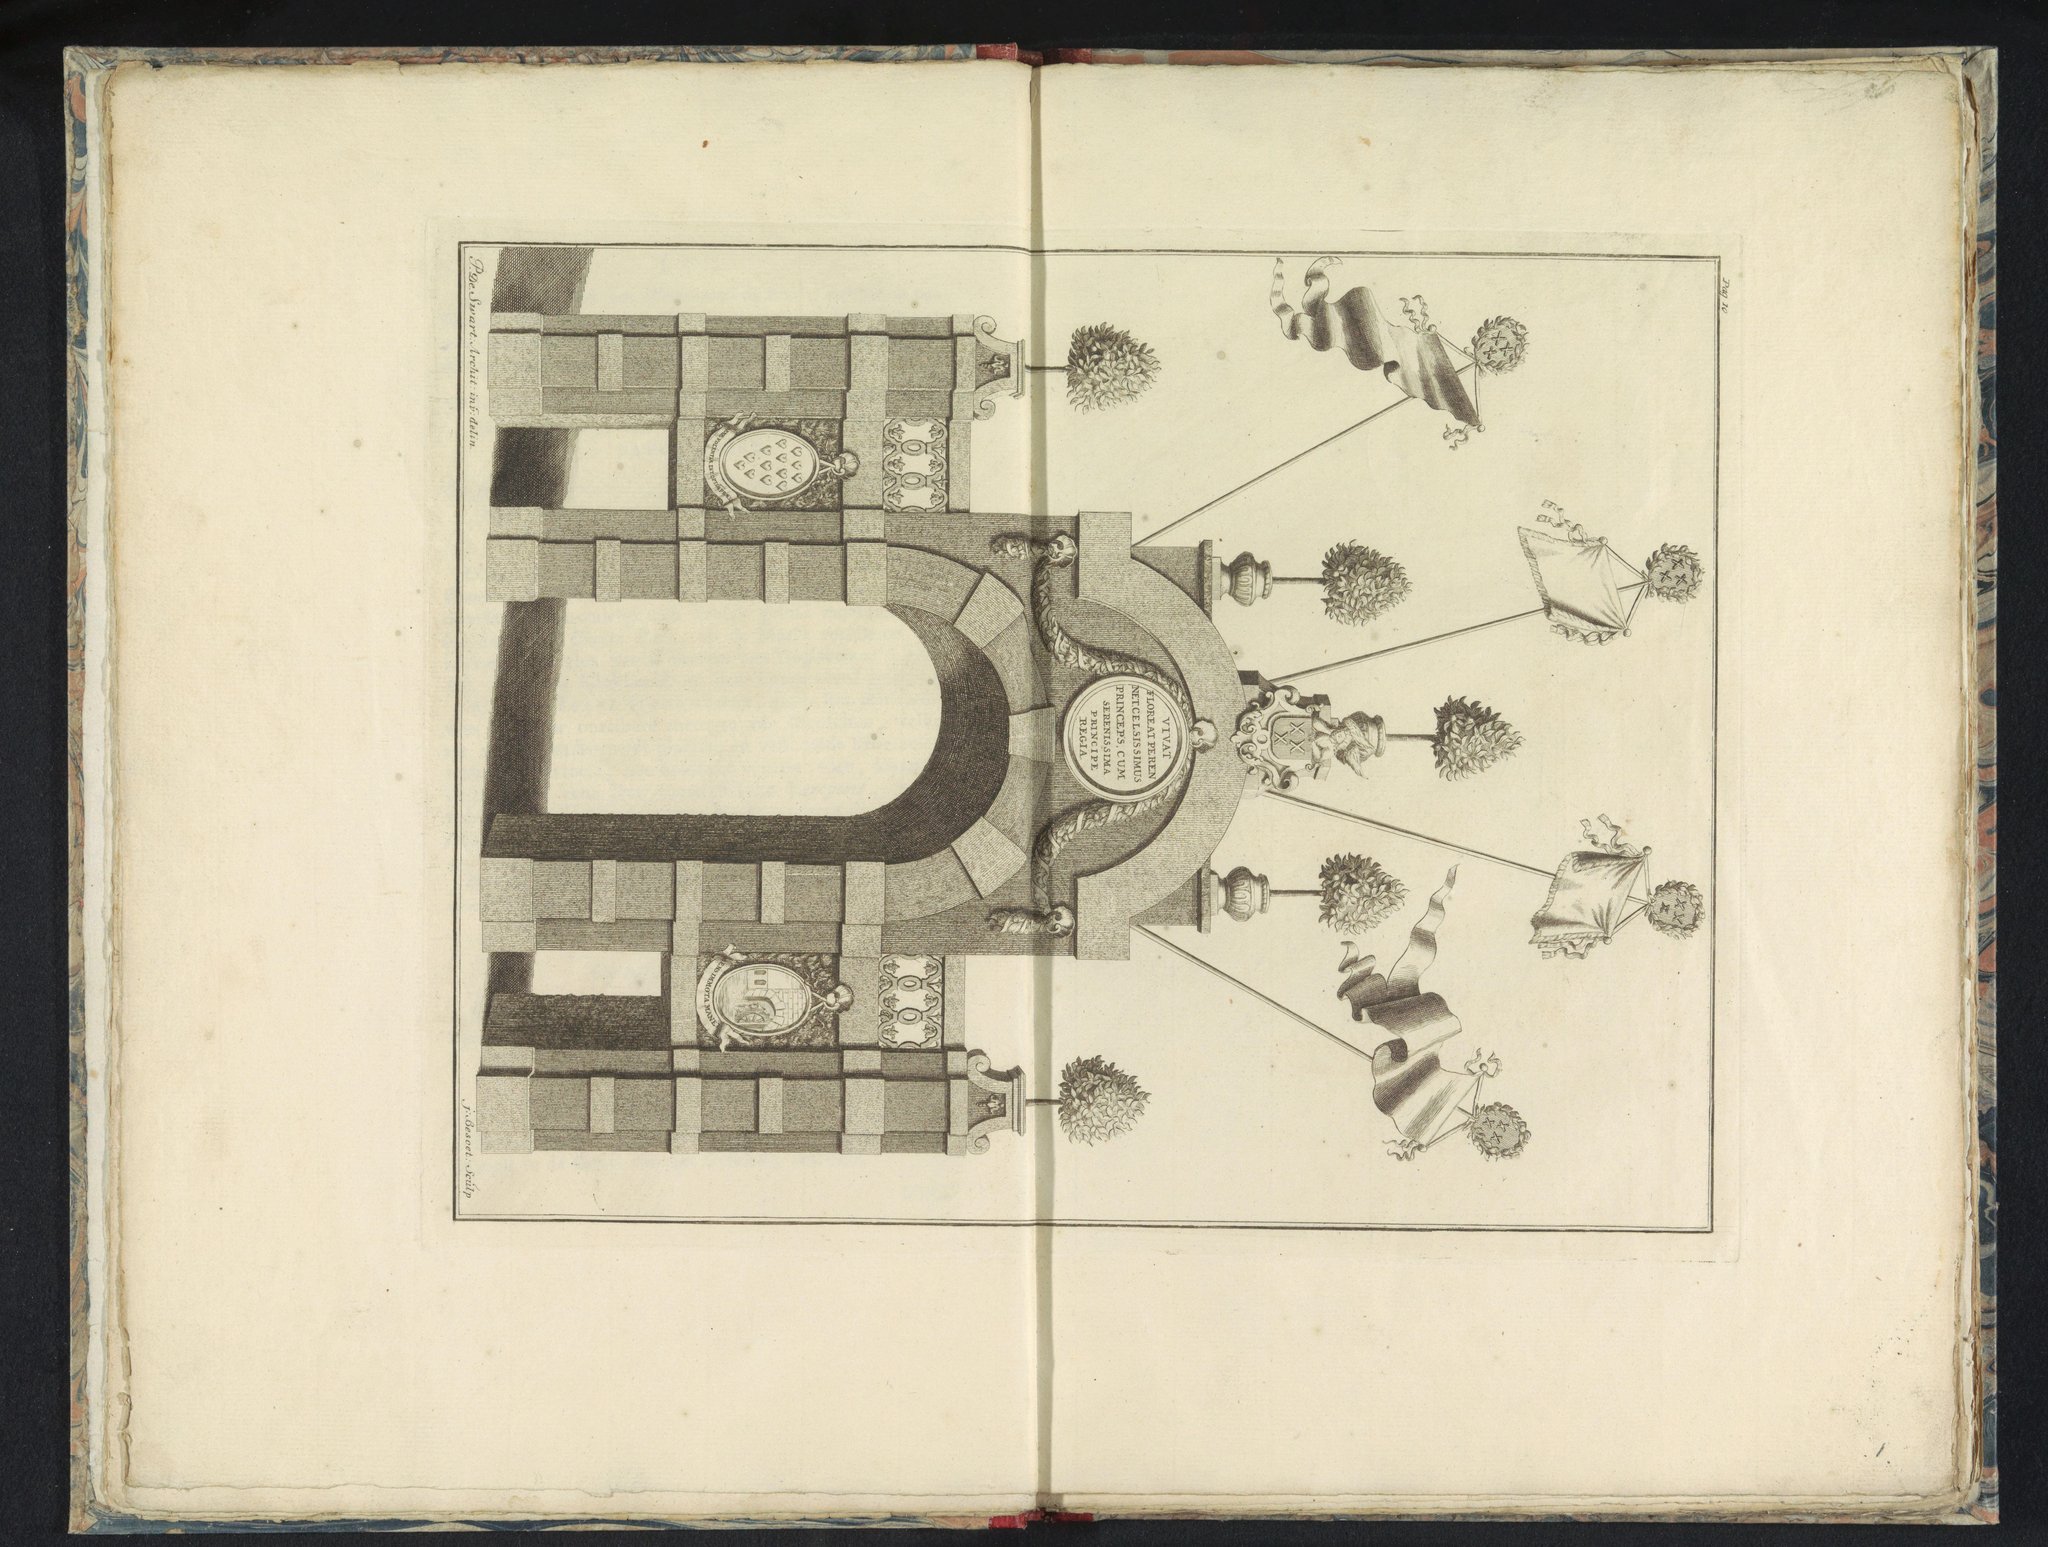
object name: print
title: Triomfpoort aan de Bosstraat bij de intrede van Willem IV te Breda, 1737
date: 1737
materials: paper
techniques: engraving, etching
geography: northern netherlands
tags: willem iv (prins van oranje-nassau), anna van hannover, triumphal arch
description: Triomfpoort opgericht in de Bosstraat bij de intrede van Willem IV en zijn gemalin Anna van Hannover te Breda op 13 september 1737. De erepoort versierd met emblemen, spreuken en vaandels. Gemerkt linksboven: Pag 10.